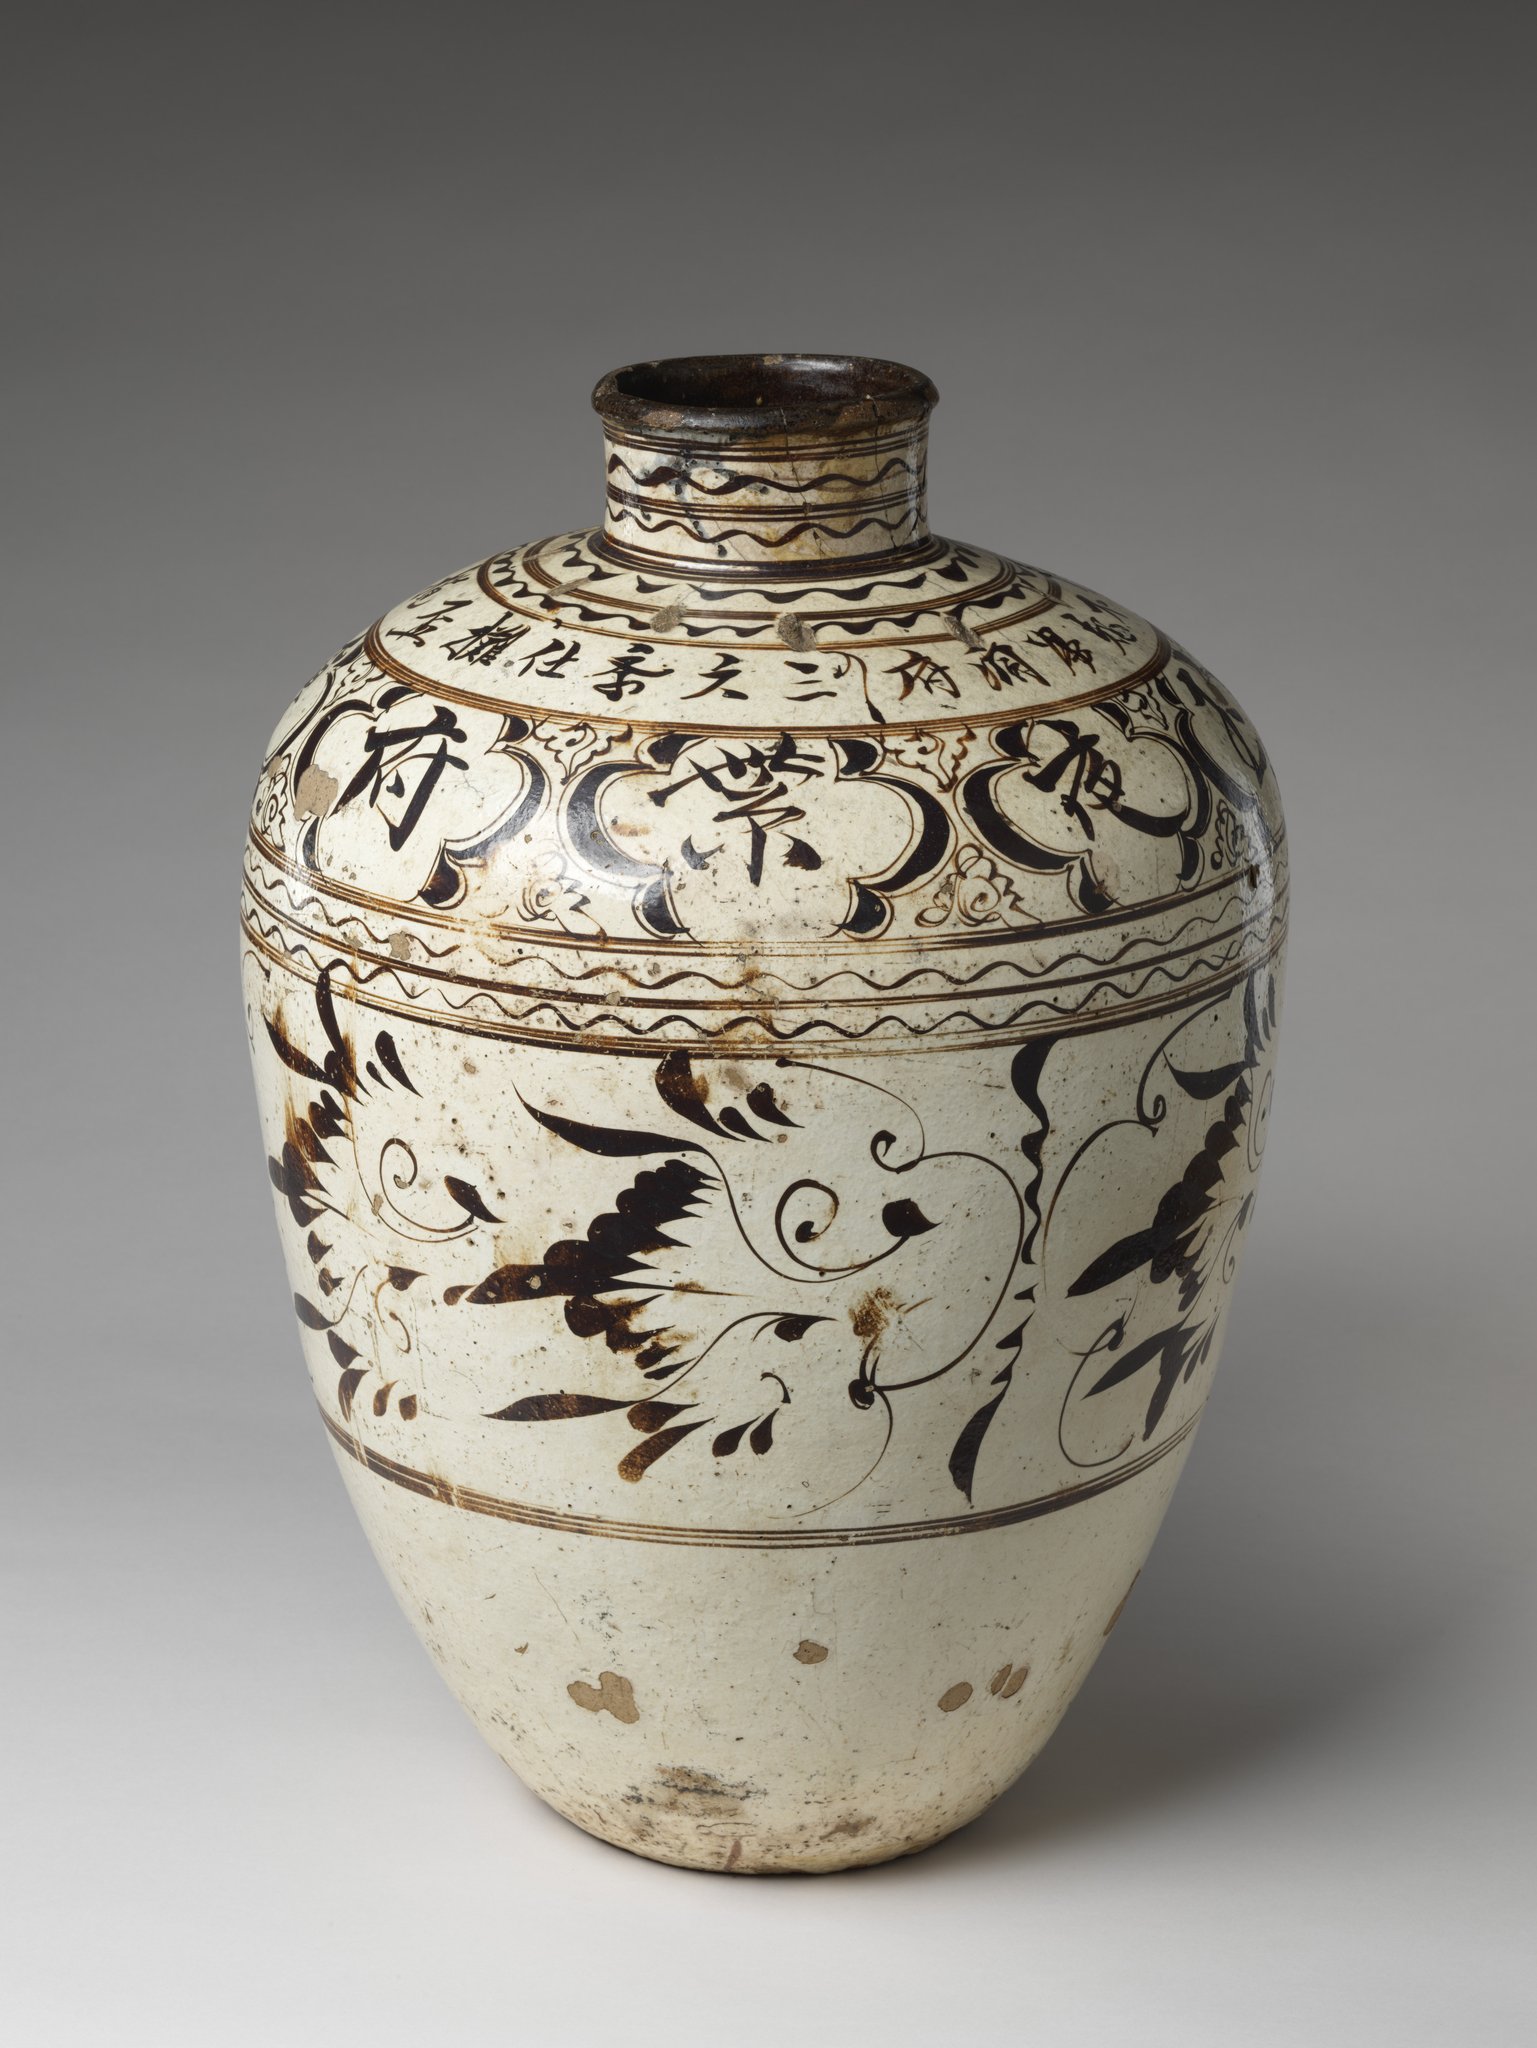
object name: jar, wine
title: Large wine jar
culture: chinese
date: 1567-1600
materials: stoneware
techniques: painting